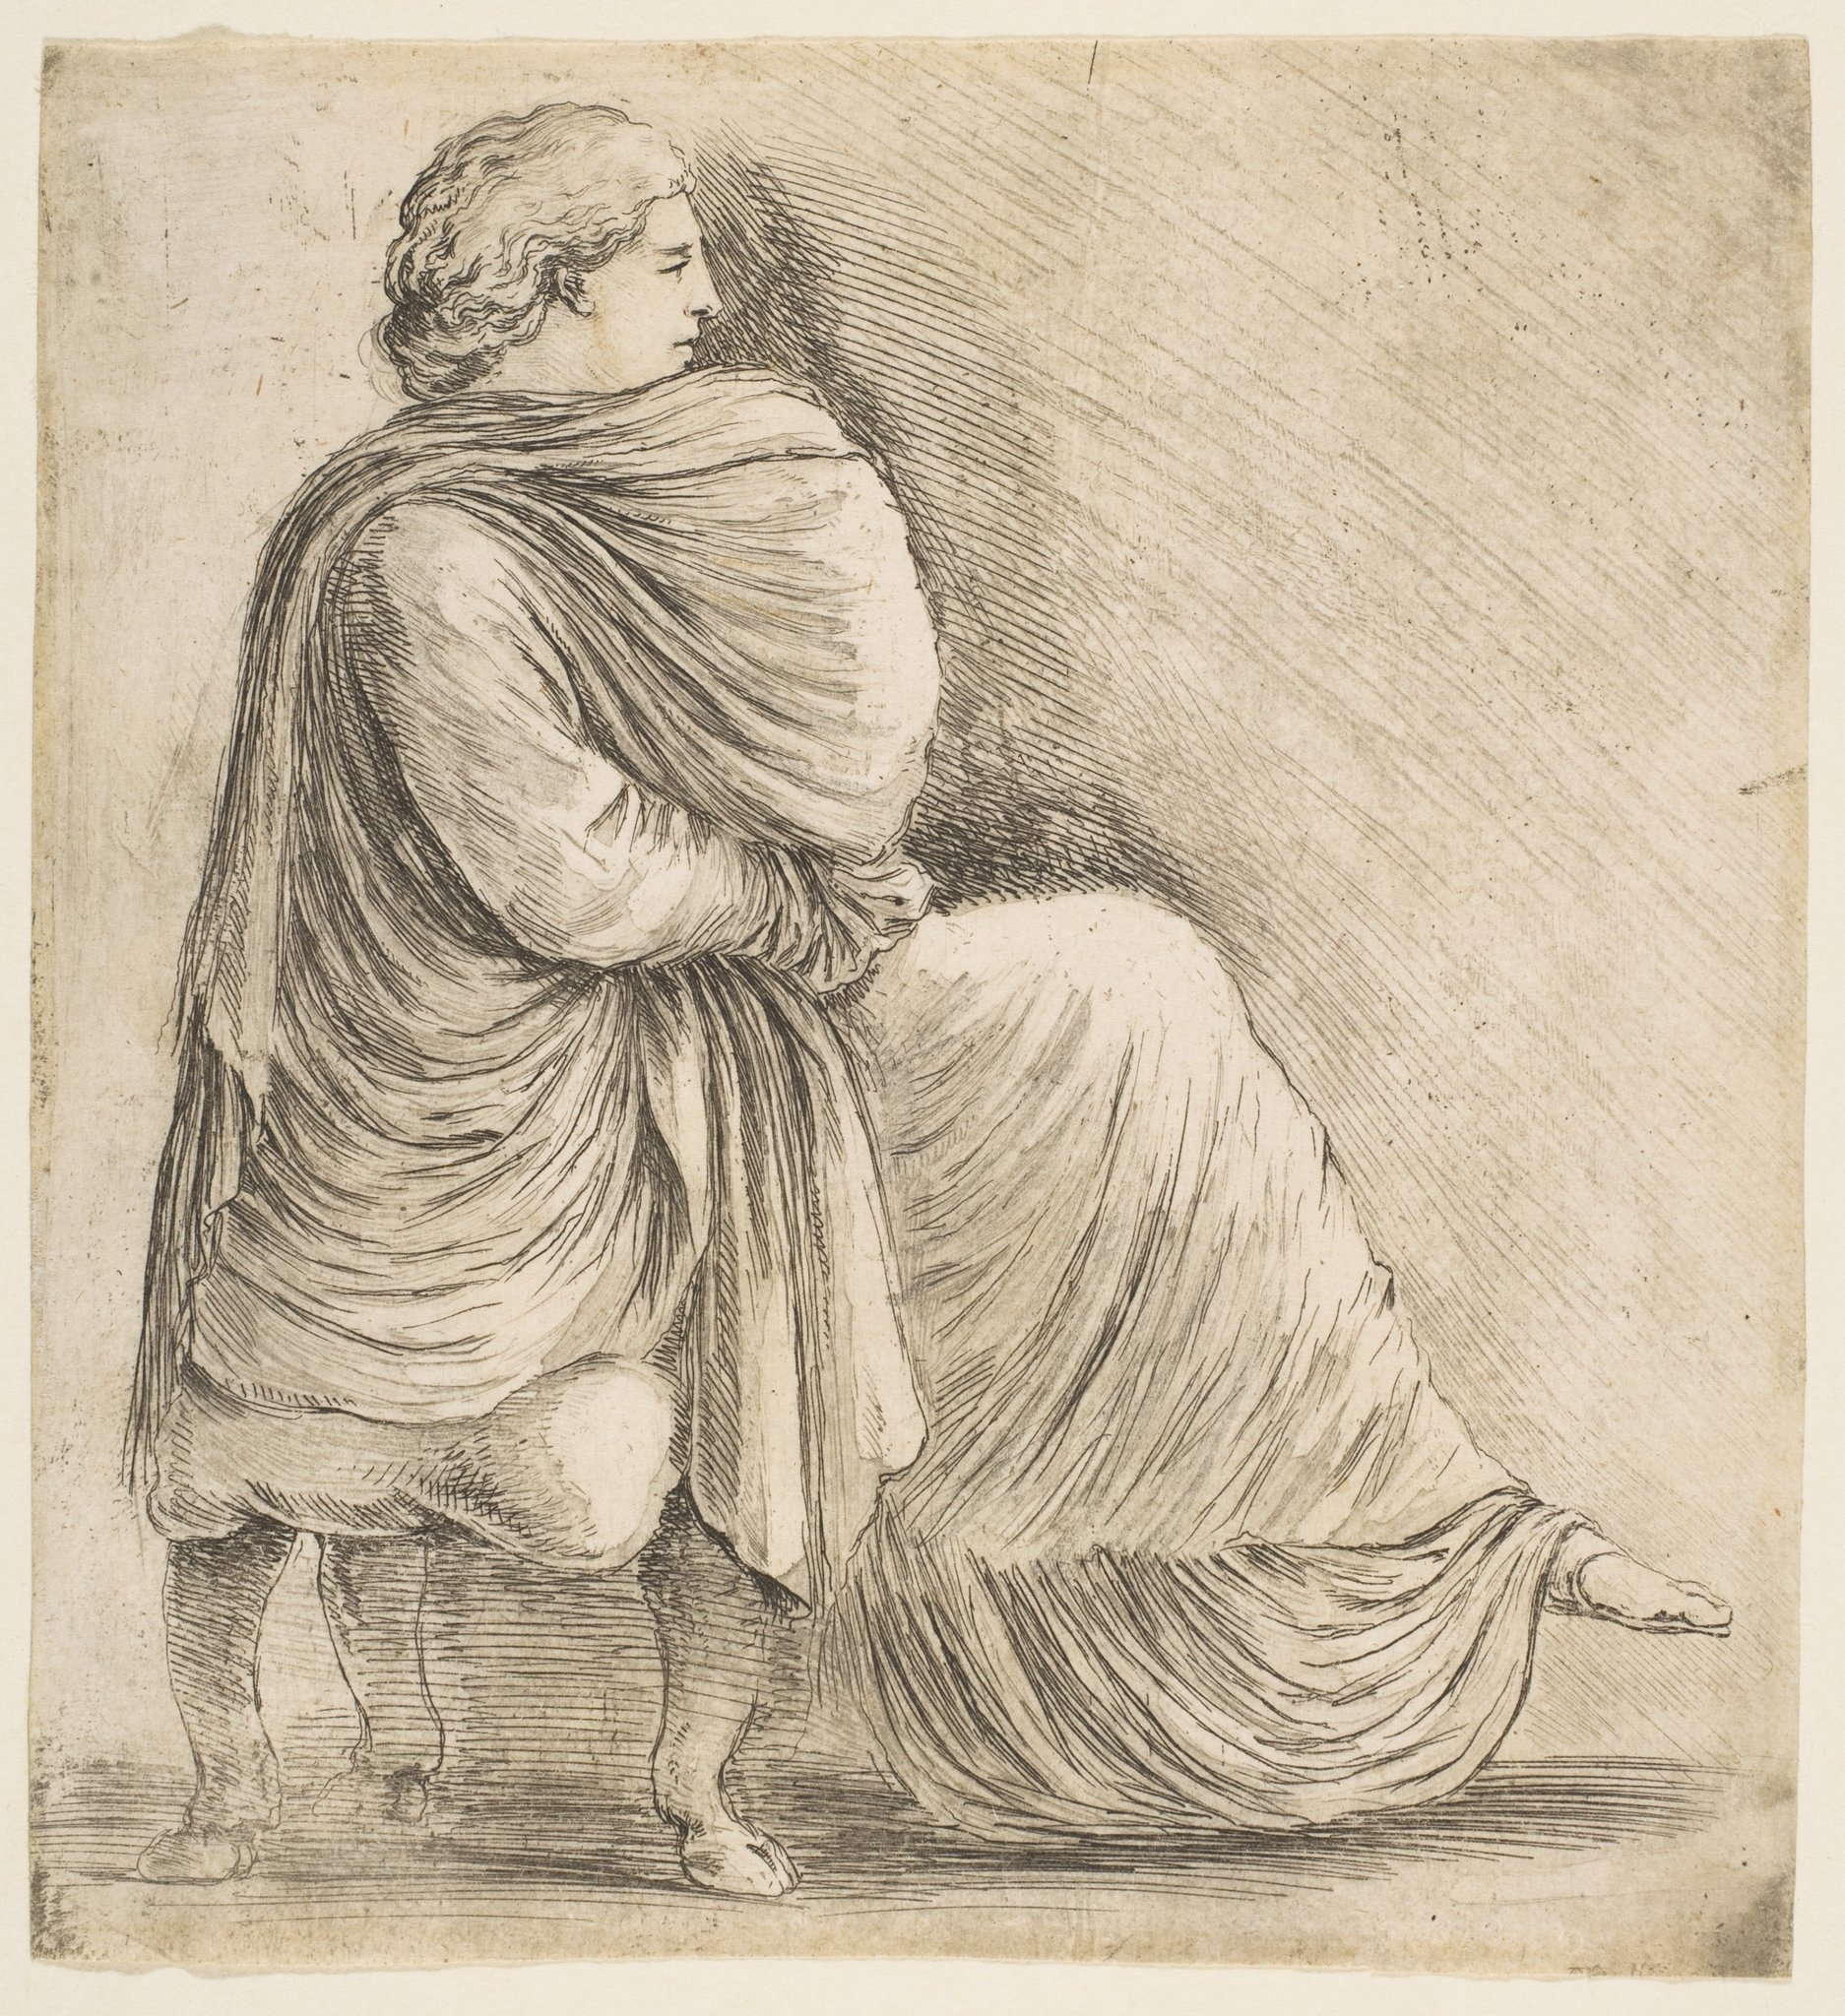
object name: print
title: Seated Woman in Profile after Antique Bas Relief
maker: stefano della bella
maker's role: artist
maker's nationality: italian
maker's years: 1610-1664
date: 1660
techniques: etching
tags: profiles,women